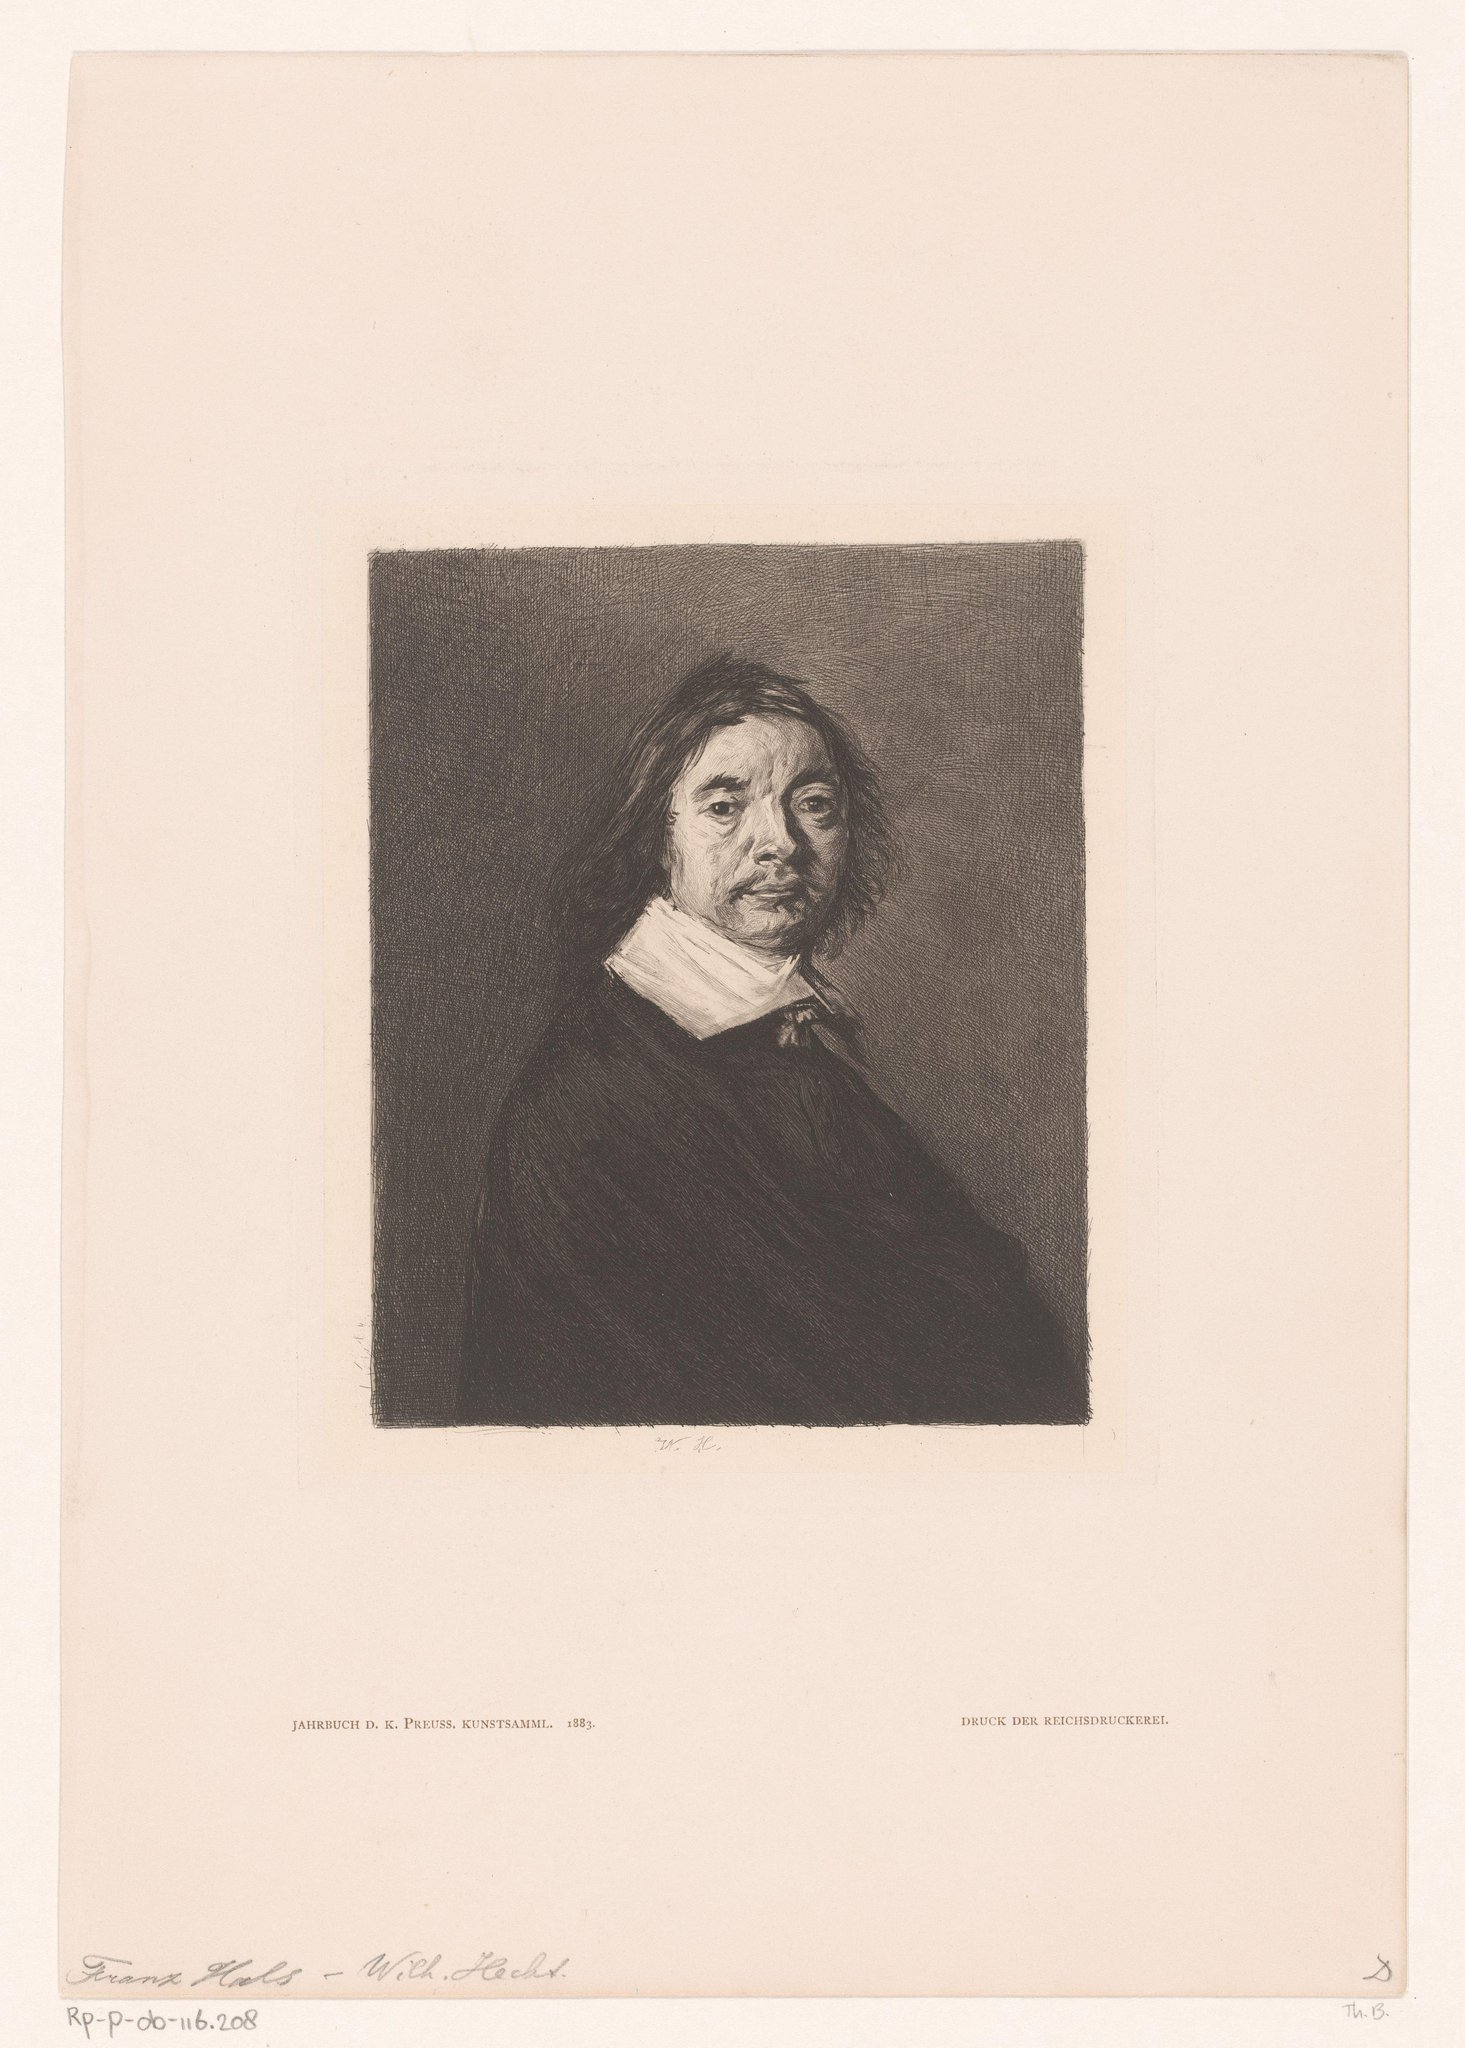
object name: print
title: Portret van een onbekende man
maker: wilhelm hecht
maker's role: print maker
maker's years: 1843-1920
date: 1883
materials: paper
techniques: etching, intaglio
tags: anonymous historical person portrayed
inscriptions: collector's mark: Lugt 2228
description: Prent uit: Bode, W. Jahrbuch der Preußischen Kunstsammlungen. S.l.s.n., 1883.